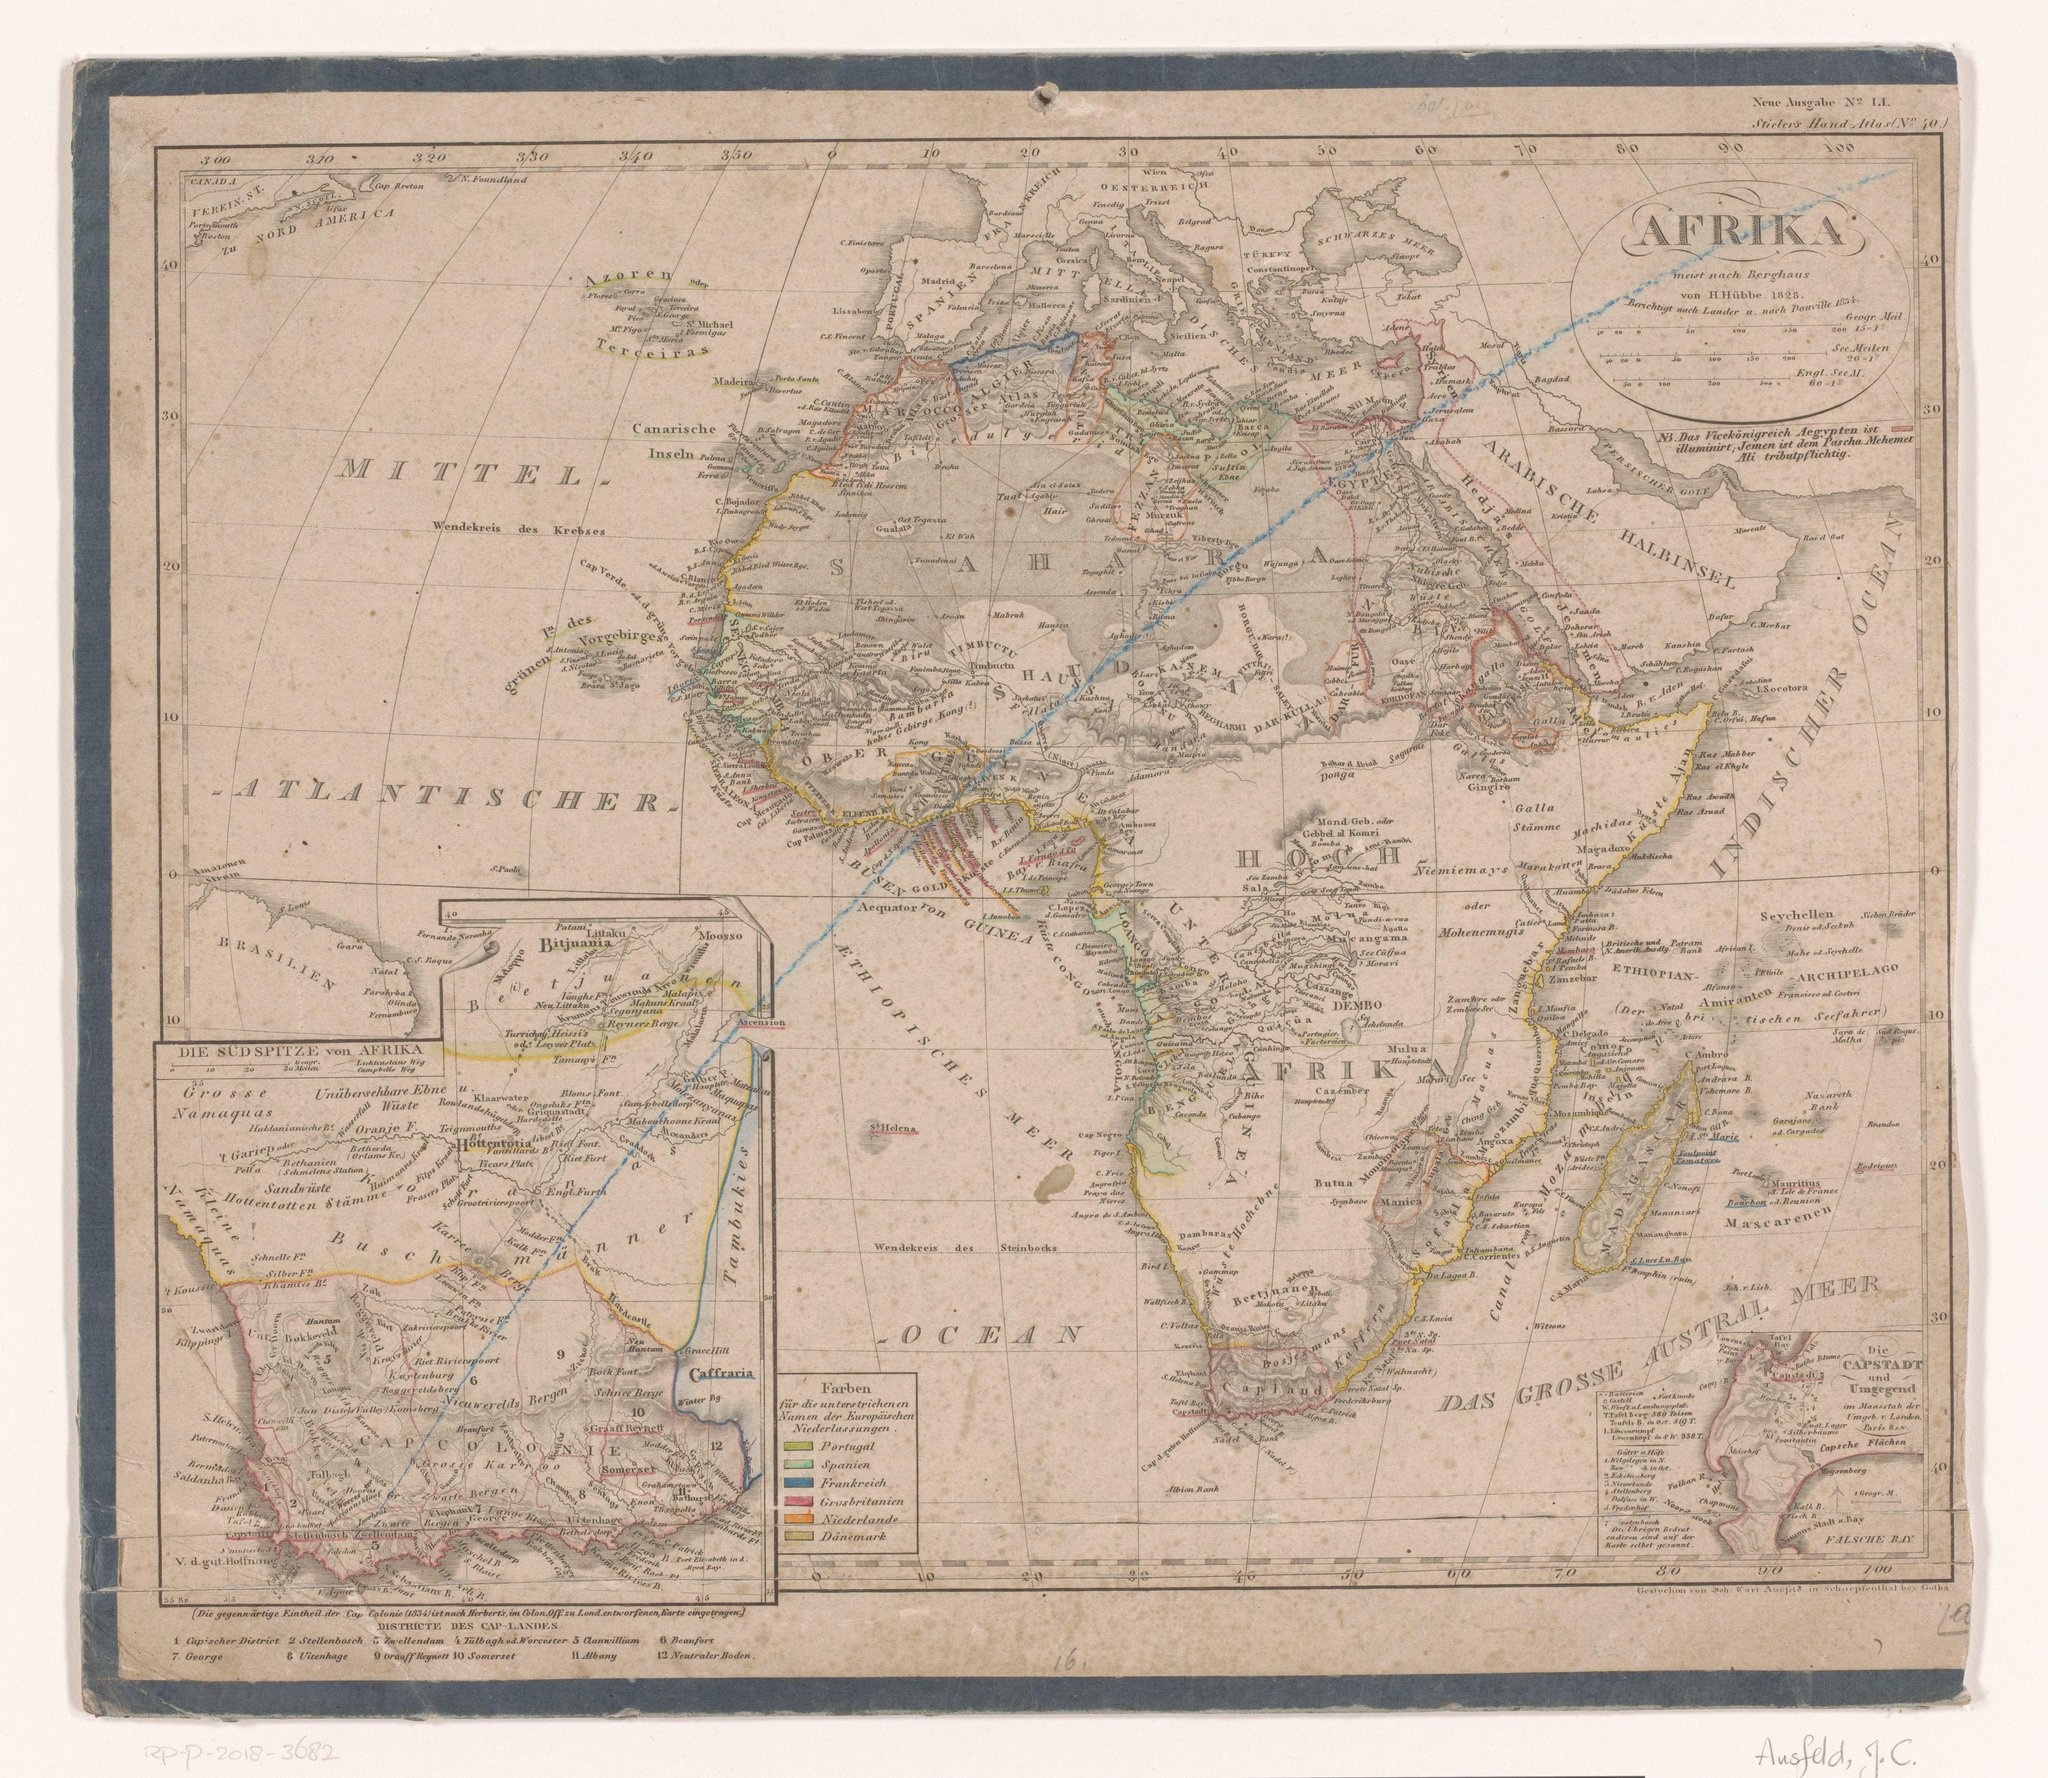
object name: print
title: Afrika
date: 1828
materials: cardboard, paper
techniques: engraving, etching, hand coloring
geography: gotha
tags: (map of) africa, maps, atlases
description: Prent uit: Stieler, Adolf. Stielers Handatlas. Gotha: Uitgeverij Justus Perthes, 1834, dl. 1.